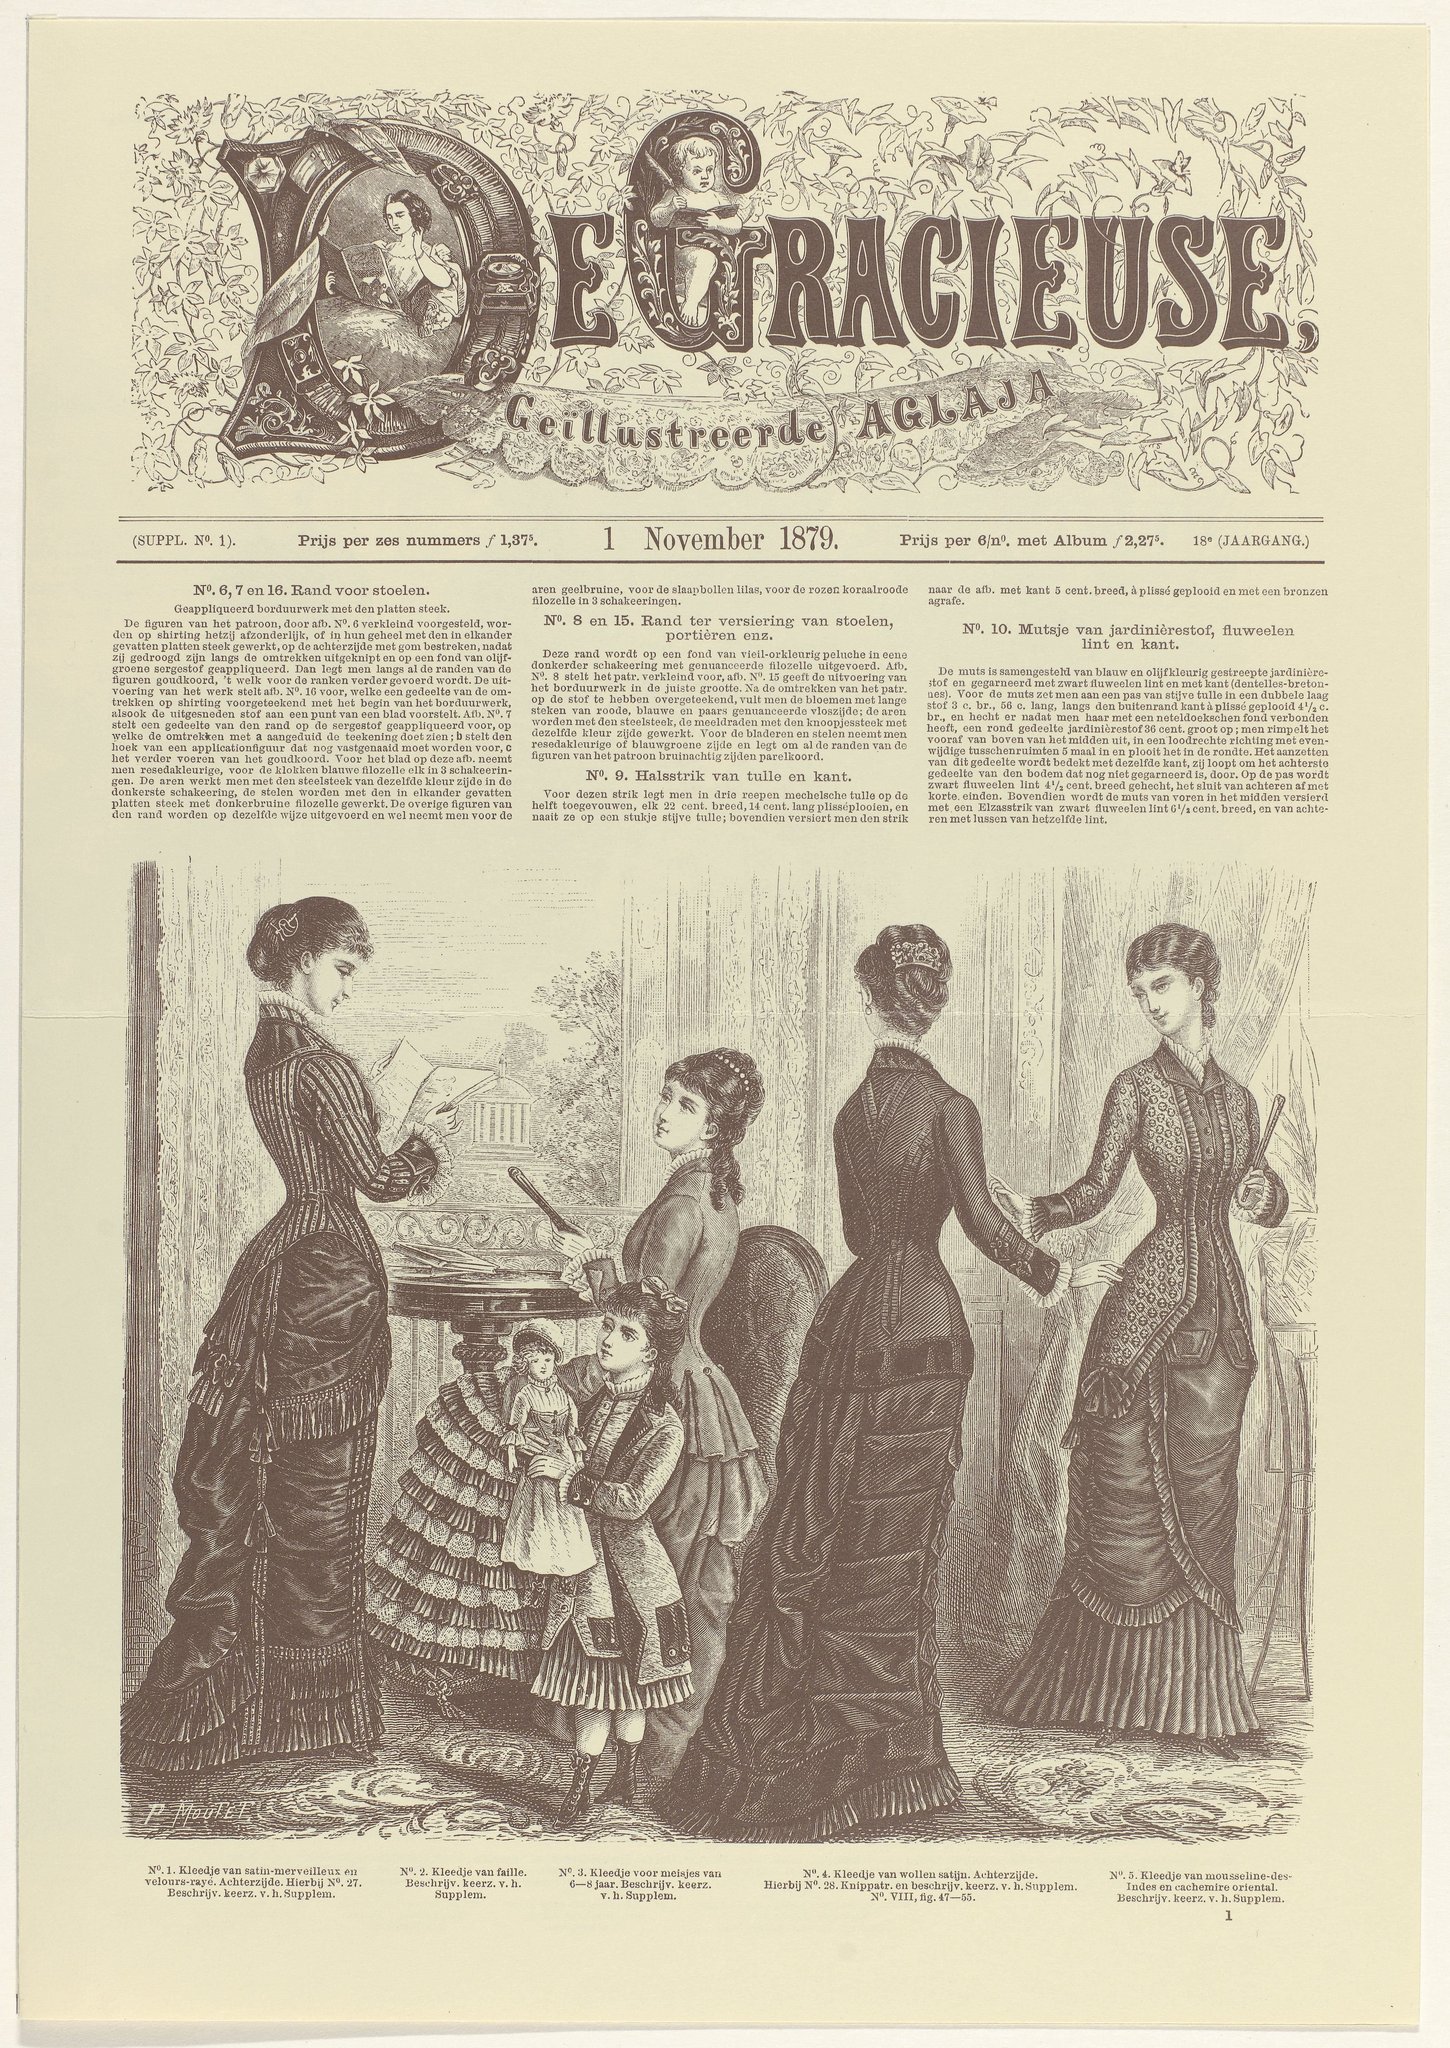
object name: fashion print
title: De Gracieuse, Geïllustreerde Aglaja, 1 november 1879, Suppl. No.1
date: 1879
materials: paper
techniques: engraving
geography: amsterdam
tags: fashion plates, dress, gown (+ women's clothes)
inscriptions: inscription: ‘DE GRACIEUSE, Geïllustreerde AGLAJA / (SUPPL. No. 1) Prijs per zes nummers f 1,375. 1 November 1879. Prijs per 6/no. met Album f 2,275. 18e (JAARGANG.)’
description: Prent uit het modetijdschrift De Gracieuse (1865-1936).